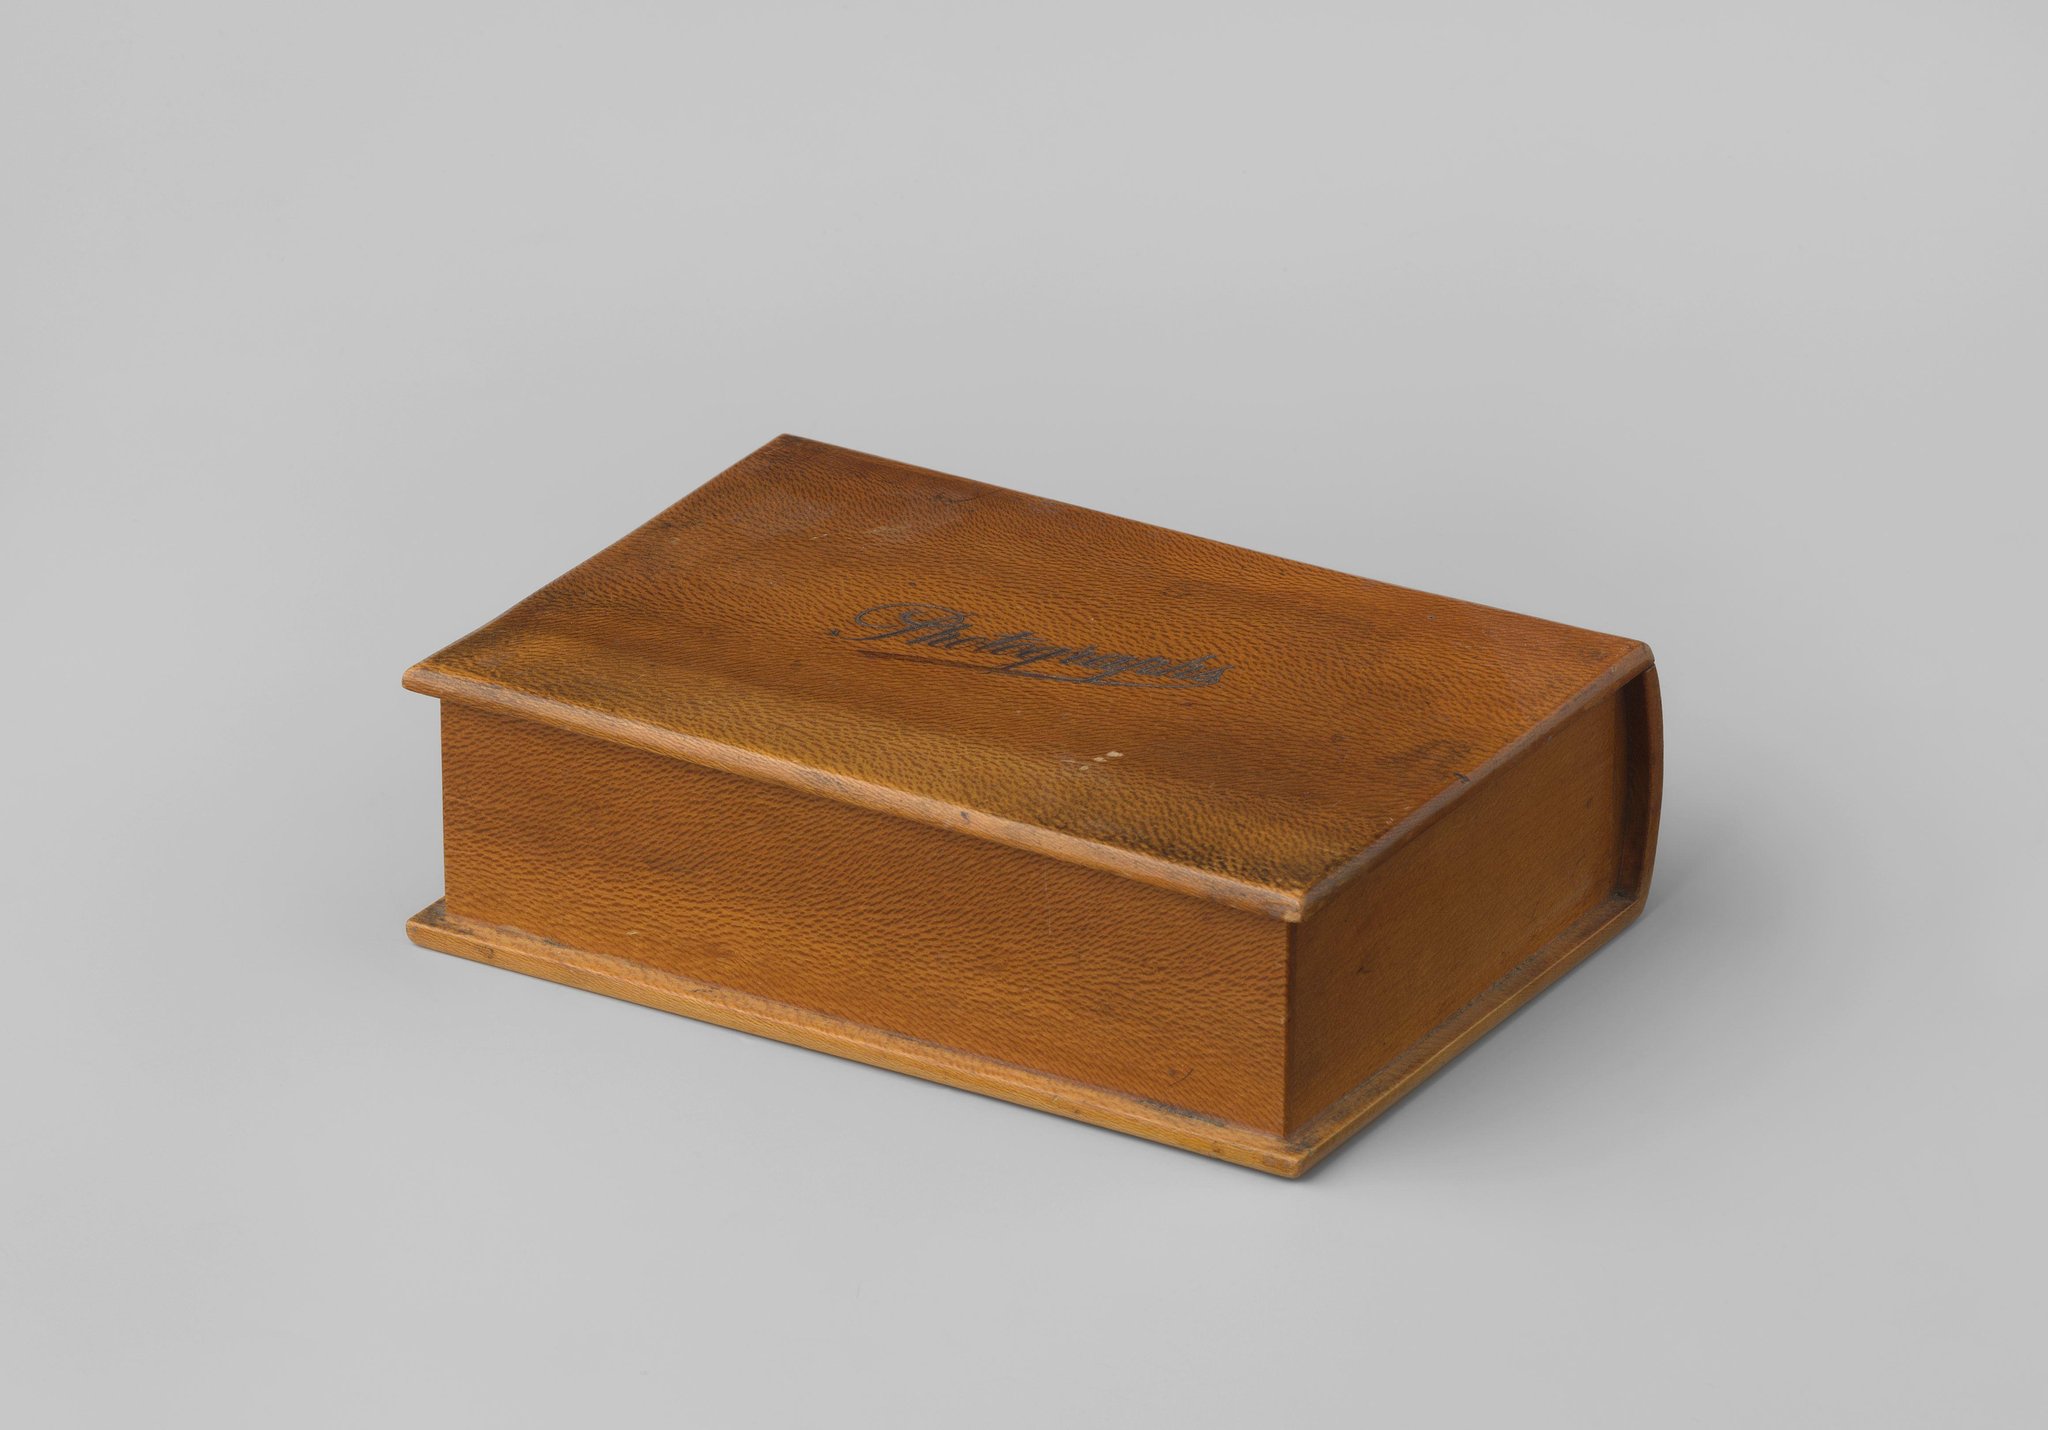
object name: photograph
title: Houten doosje met opschrift 'Photographs'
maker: Anonymous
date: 1870-1885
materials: cardboard, paper, photographic support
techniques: albumen print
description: Houten doosje met opschrift 'Photographs', gebruikt om foto's op te bergen.